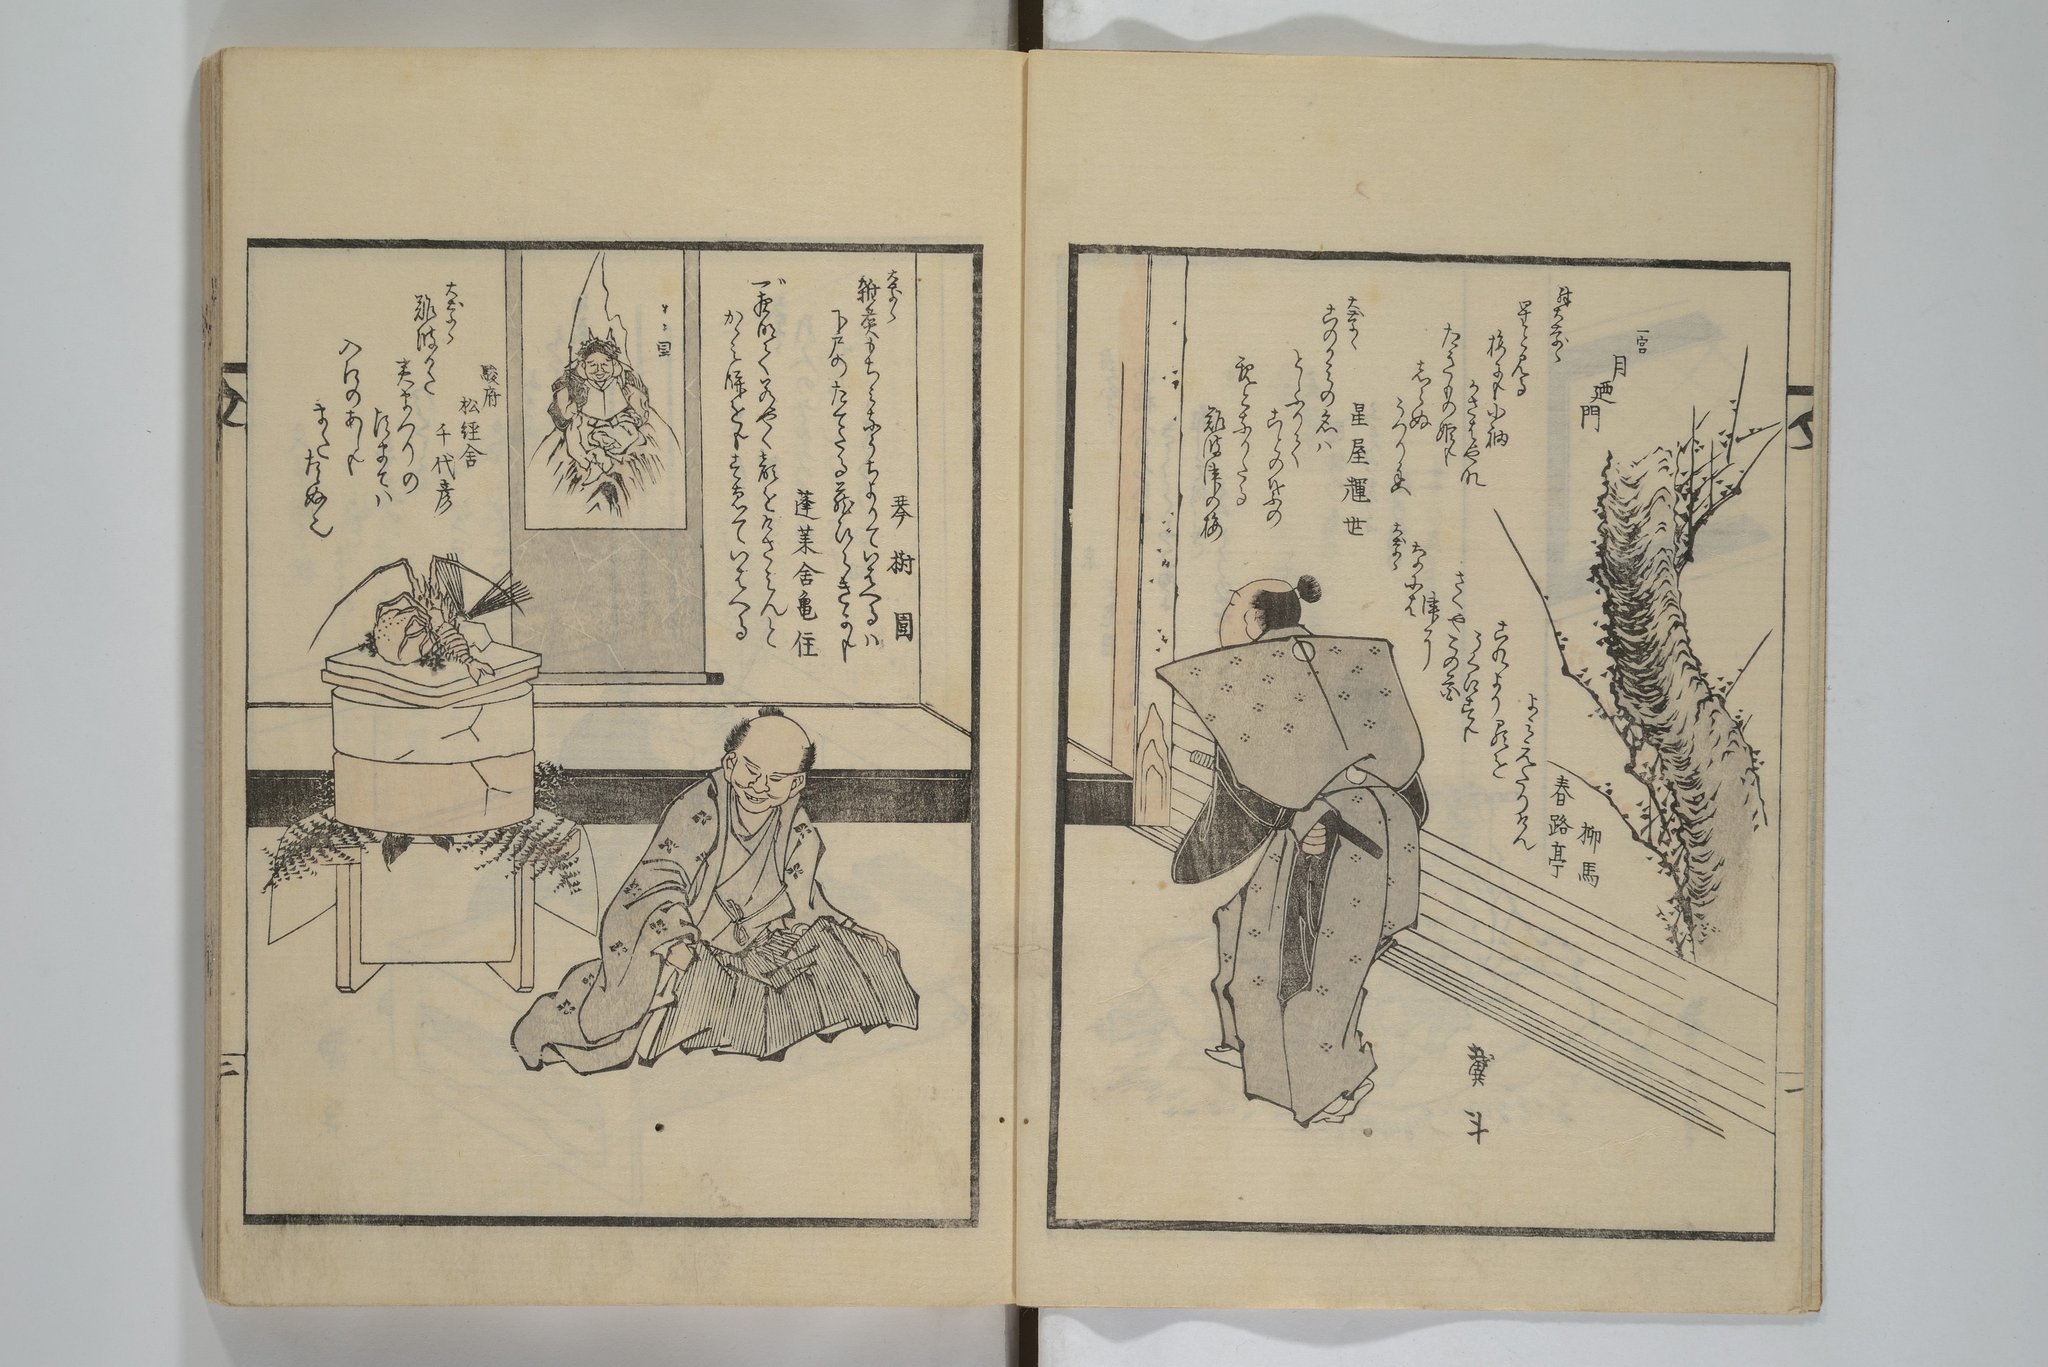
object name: illustrated book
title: Illustrated Collection of the Famous Products of Japan (Nihon meibutsu gasan shū) 日本名物画賛集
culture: japanese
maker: katsushika taito 葛飾 戴斗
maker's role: artist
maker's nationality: japanese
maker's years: 1810-1850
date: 1820-1829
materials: ink, paper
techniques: woodblock print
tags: men